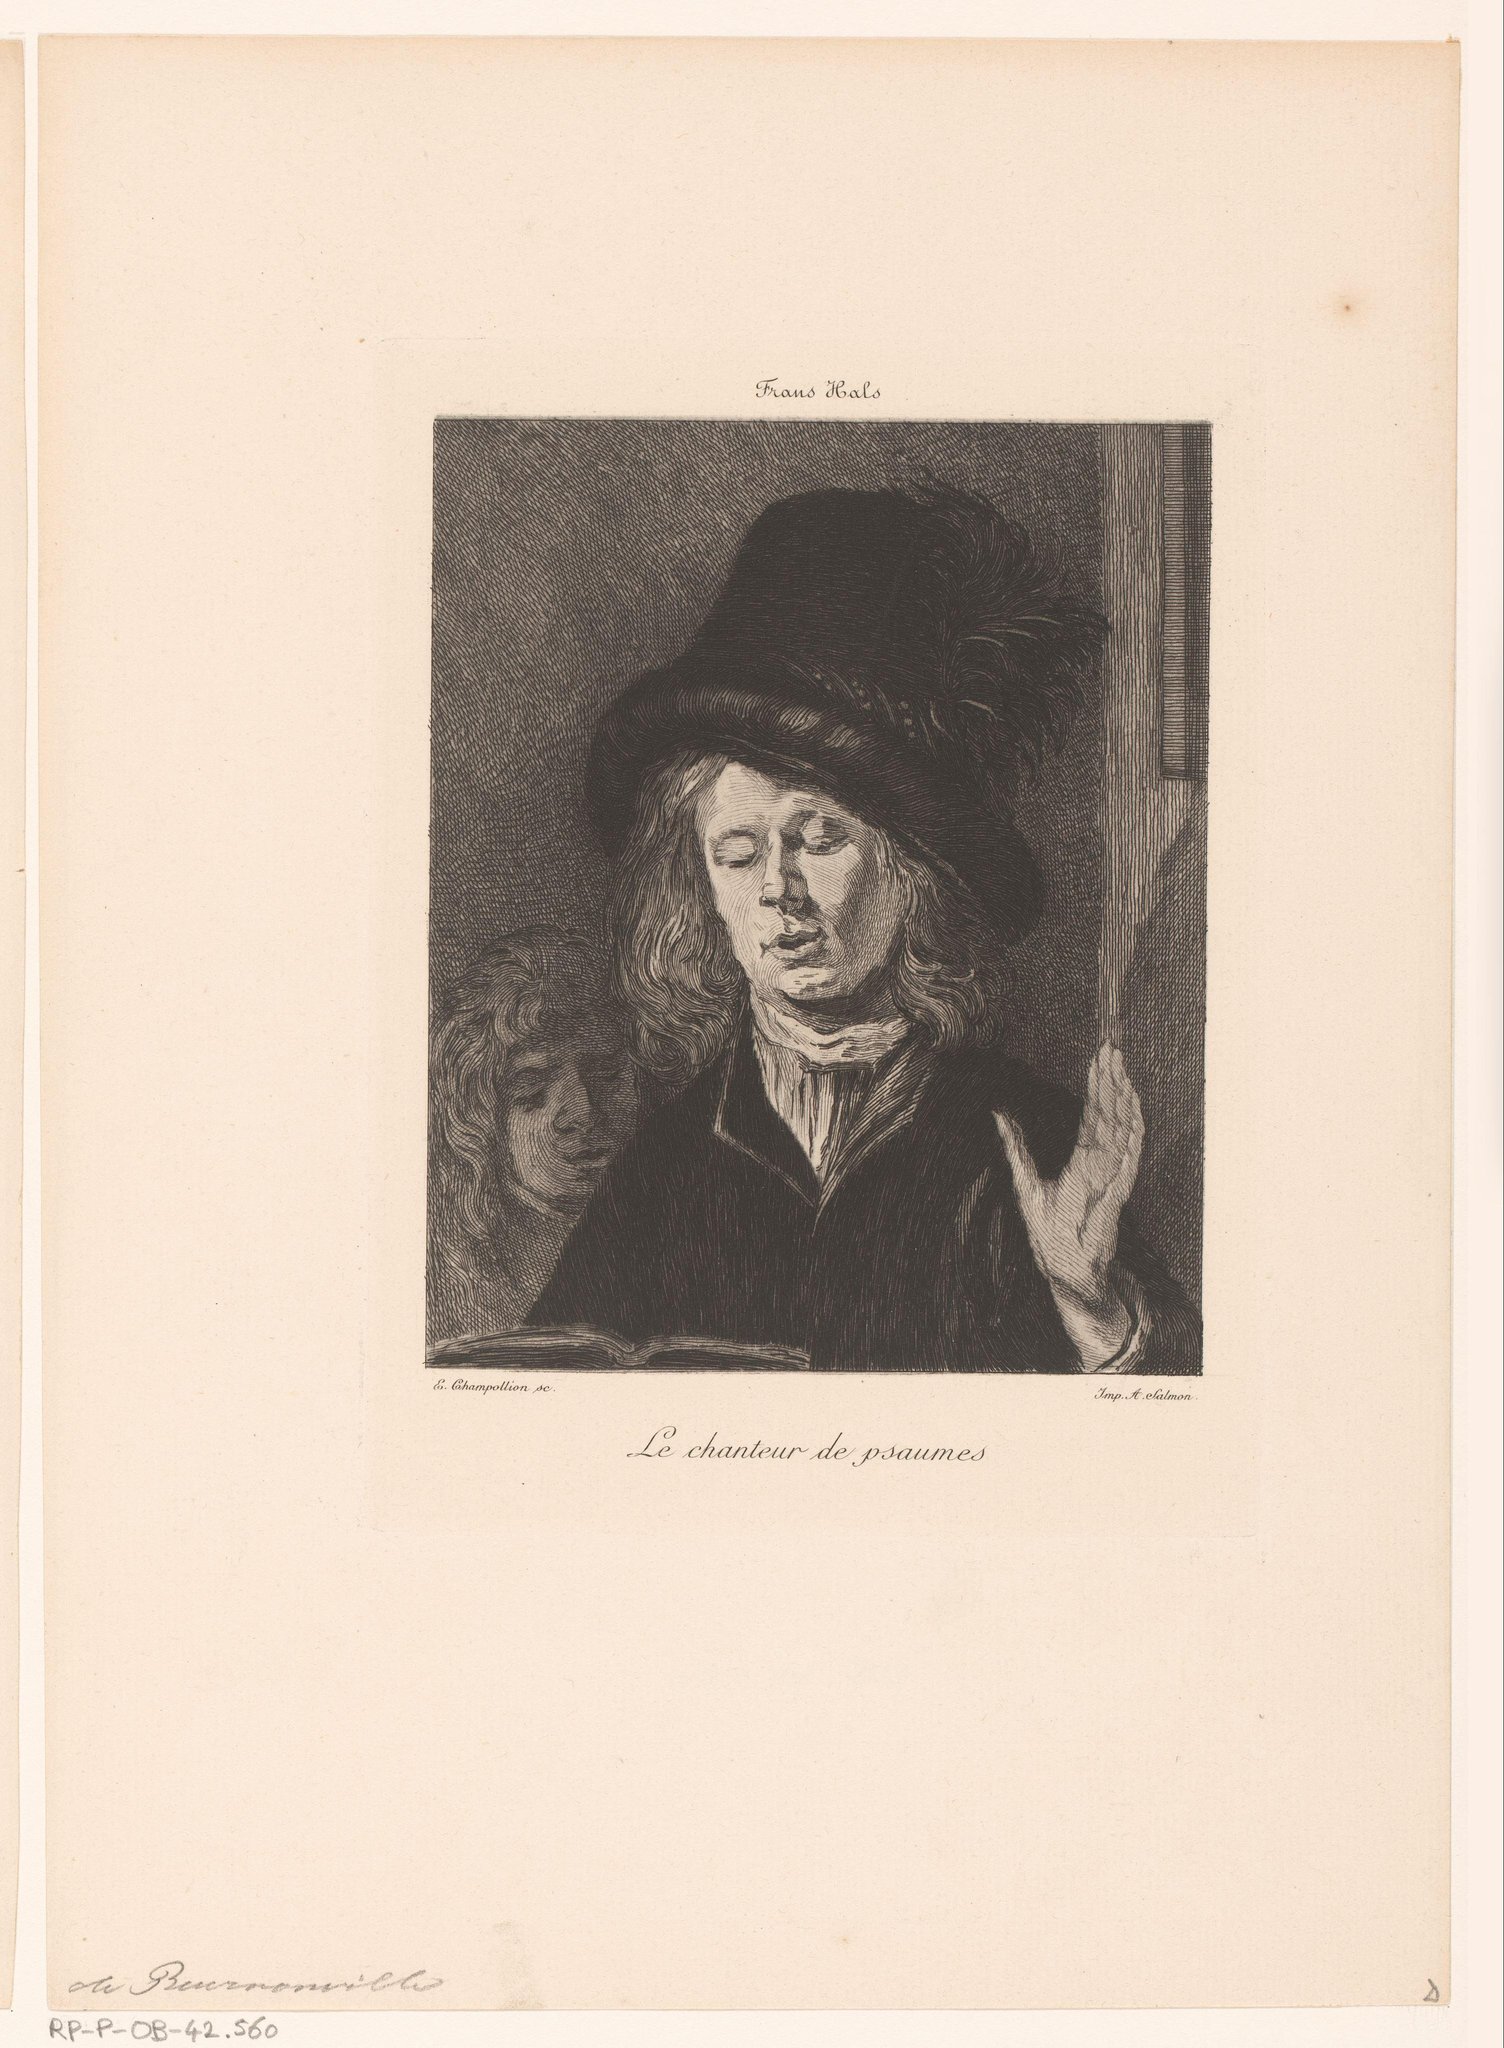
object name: book illustration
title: Man uit een psalmboek zingend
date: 1881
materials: paper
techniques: etching, intaglio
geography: france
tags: singing of psalms, hymns, etc.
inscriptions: collector's mark: Lugt 2228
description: Prent afkomstig uit een veilingcatalogus: "Catalogue des Tableaux anciens composant la très importante collection de Monsieur le Baron de Beurnonville", uitgegeven in 1881 te Parijs door Pillet en Dumoulin. De veiling vond plaats van 9 tot en met 14 en 16 mei 1881. Deze prent betreft een illustratie bij lot 299 op p. 179.